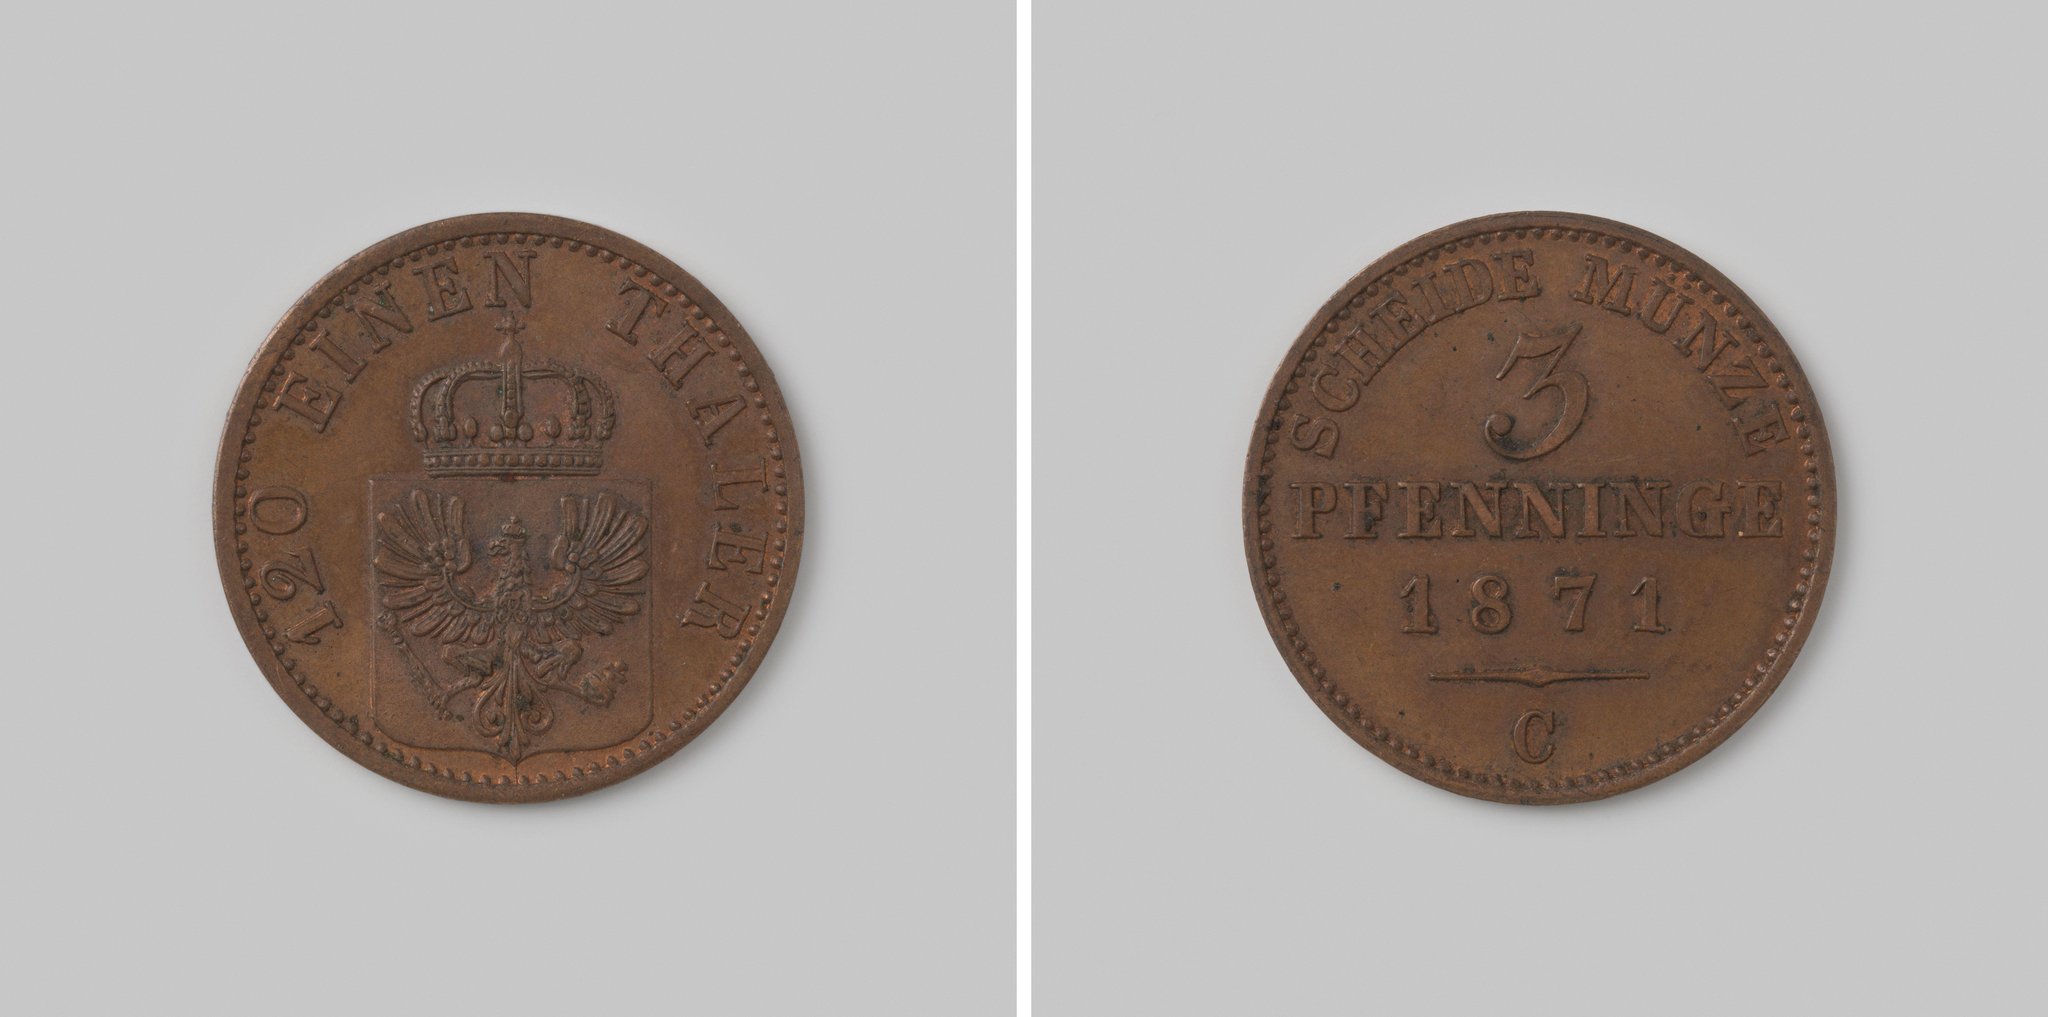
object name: coin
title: Pruisen, Wilhelm I, 3 pfenninge, 1871 C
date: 1871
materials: copper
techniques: striking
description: Koperen munt. Voorzijde: gekroond wapenschild. Keerzijde: waarde-aanduiding in twee regels. Daaronder jaartal. In afsnede letter C. Gladde rand.